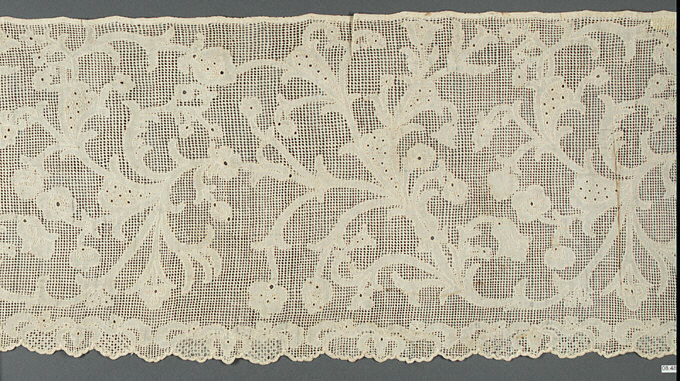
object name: flounce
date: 1701-1800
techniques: embroidery